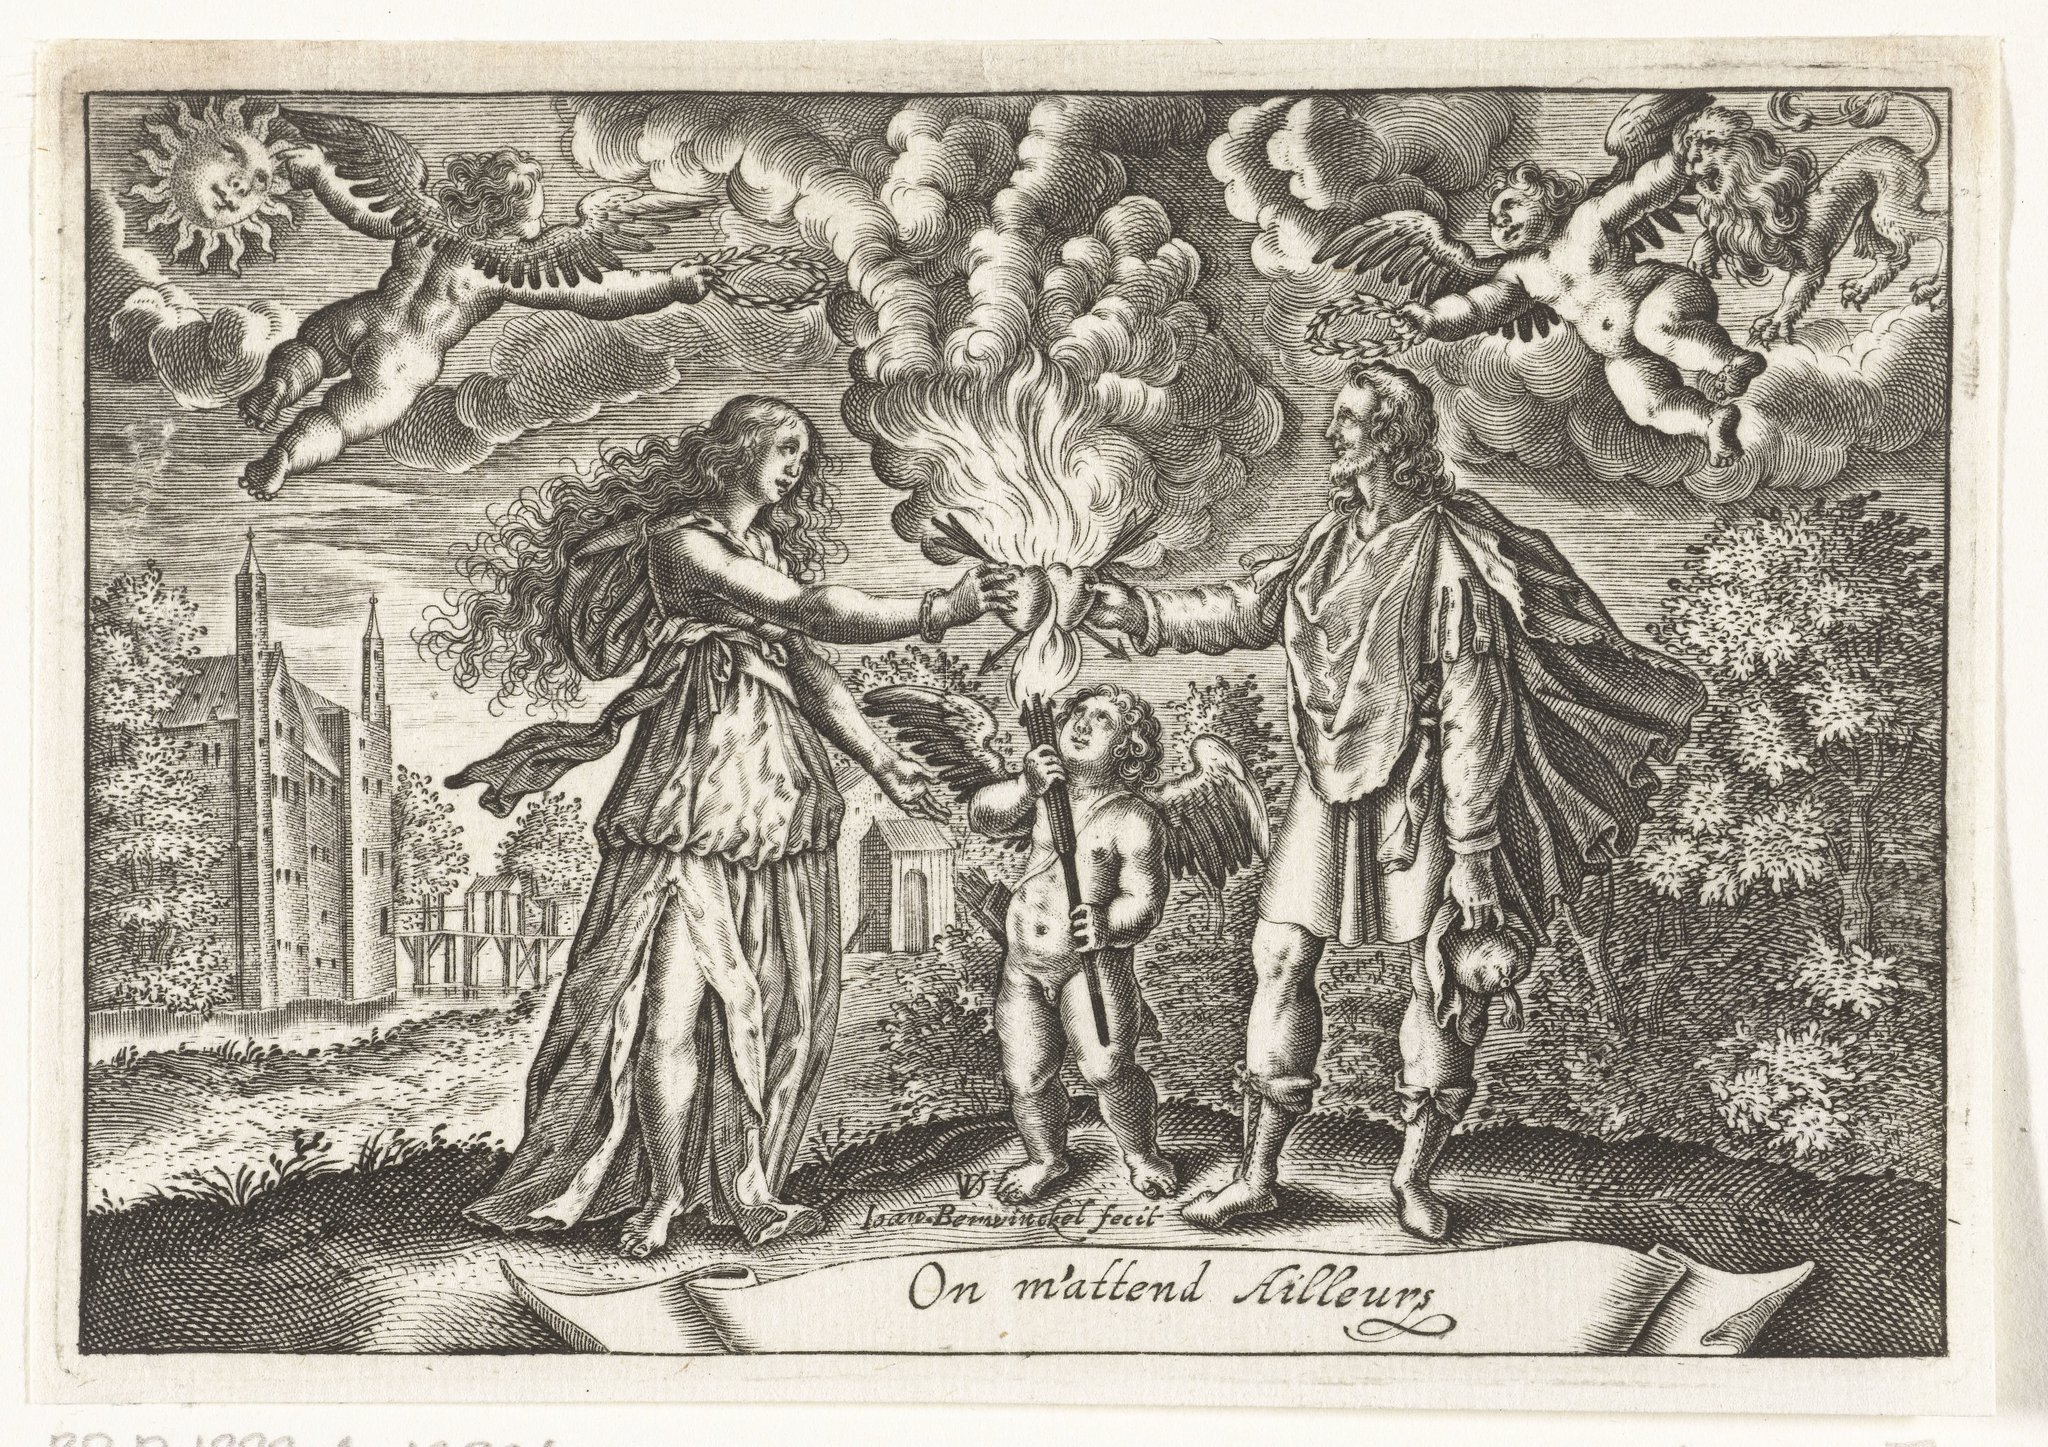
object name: print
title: Allegorische voorstelling van het huwelijk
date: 1590-1610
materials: paper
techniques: engraving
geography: low countries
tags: heart symbolism, marriage, married couple, 'matrimonium', (story of) cupid, amor (eros), armorial bearing, heraldry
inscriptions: collector's mark: Lugt 2228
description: Man en vrouw reiken elkaar een hart doorboord met een pijl en Amor laat deze harten met een brandende fakkel samensmelten als blijk van liefde. Boven beide huwelijkskandidaten zweeft een kleine engel met een krans, bij de vrouw met de zon als attribuut en bij de man een leeuw. Op een band staat het motto On m'attend ailleurs.